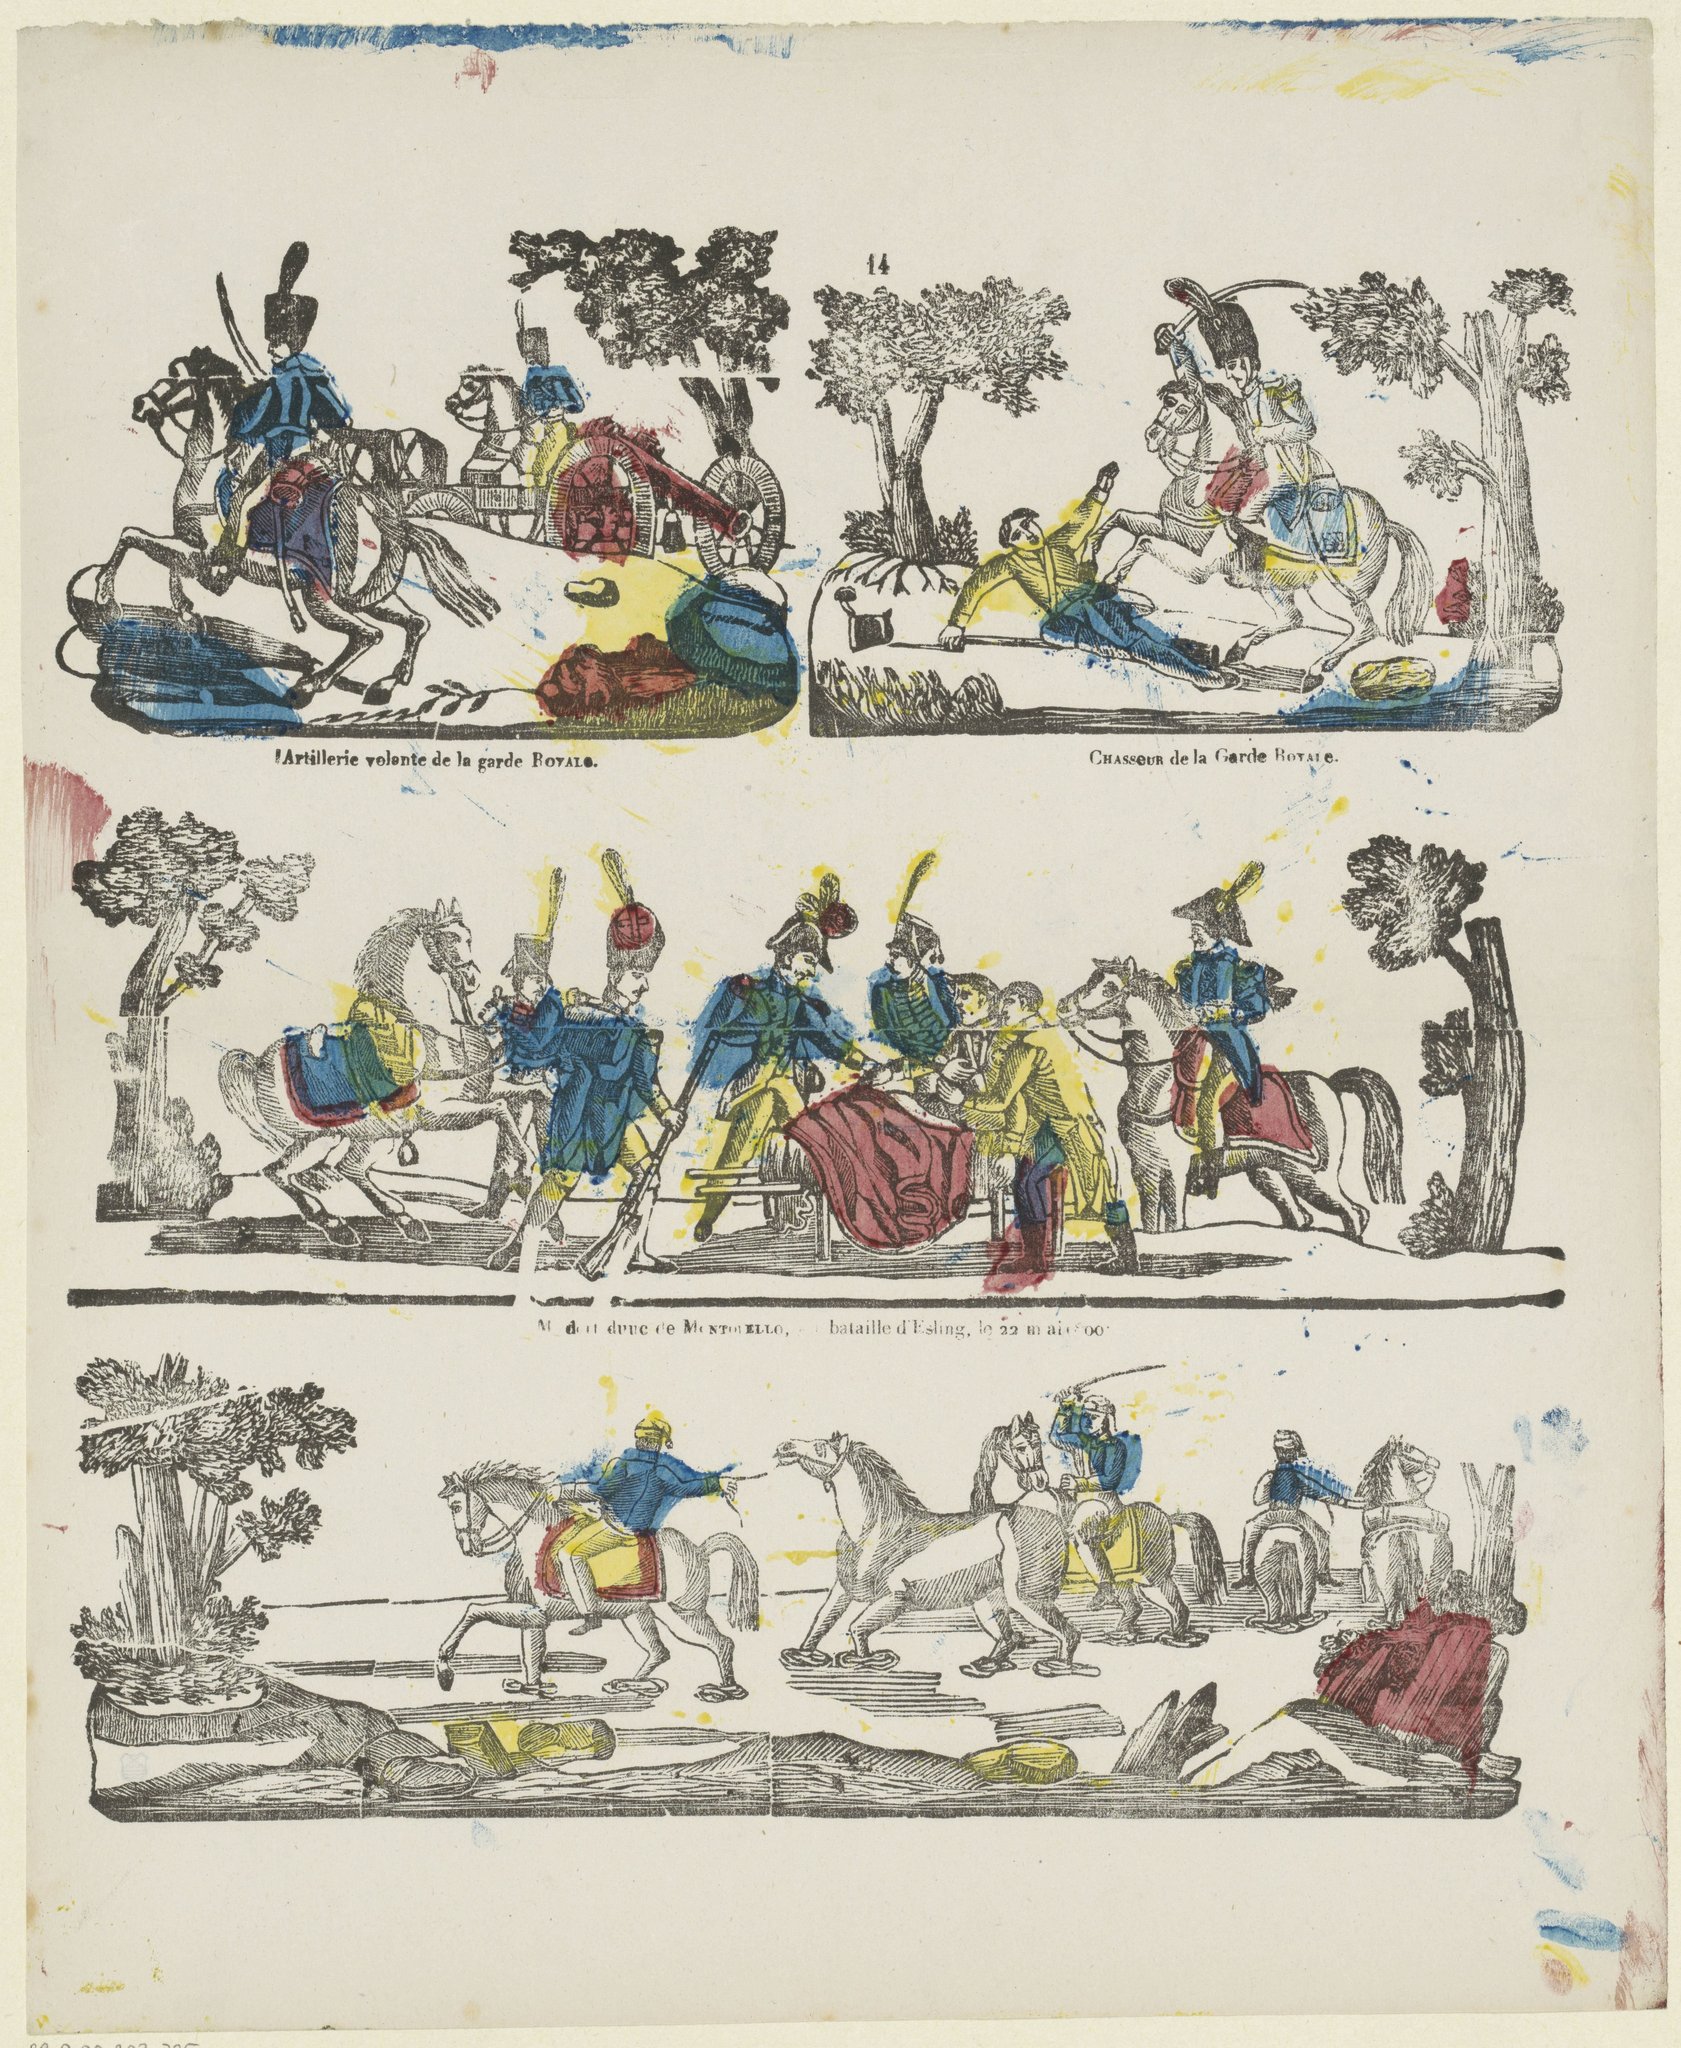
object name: popular print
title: Militairen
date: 1827-1894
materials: paper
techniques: colour, letterpress printing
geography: schaarbeek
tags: warfare; military affairs (+ cavalry, horsemen), the soldier; the soldier's life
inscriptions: collector's mark: Lugt 2760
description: Blad met 4 voorstellingen van militairen in actie, waaronder militairen tijdens de Slag bij Aspern-Eßling (een veldslag op 21 en 22 mei 1809). Onder enkele afbeeldingen een onderschrift in het Frans. Genummerd midden boven: 14.